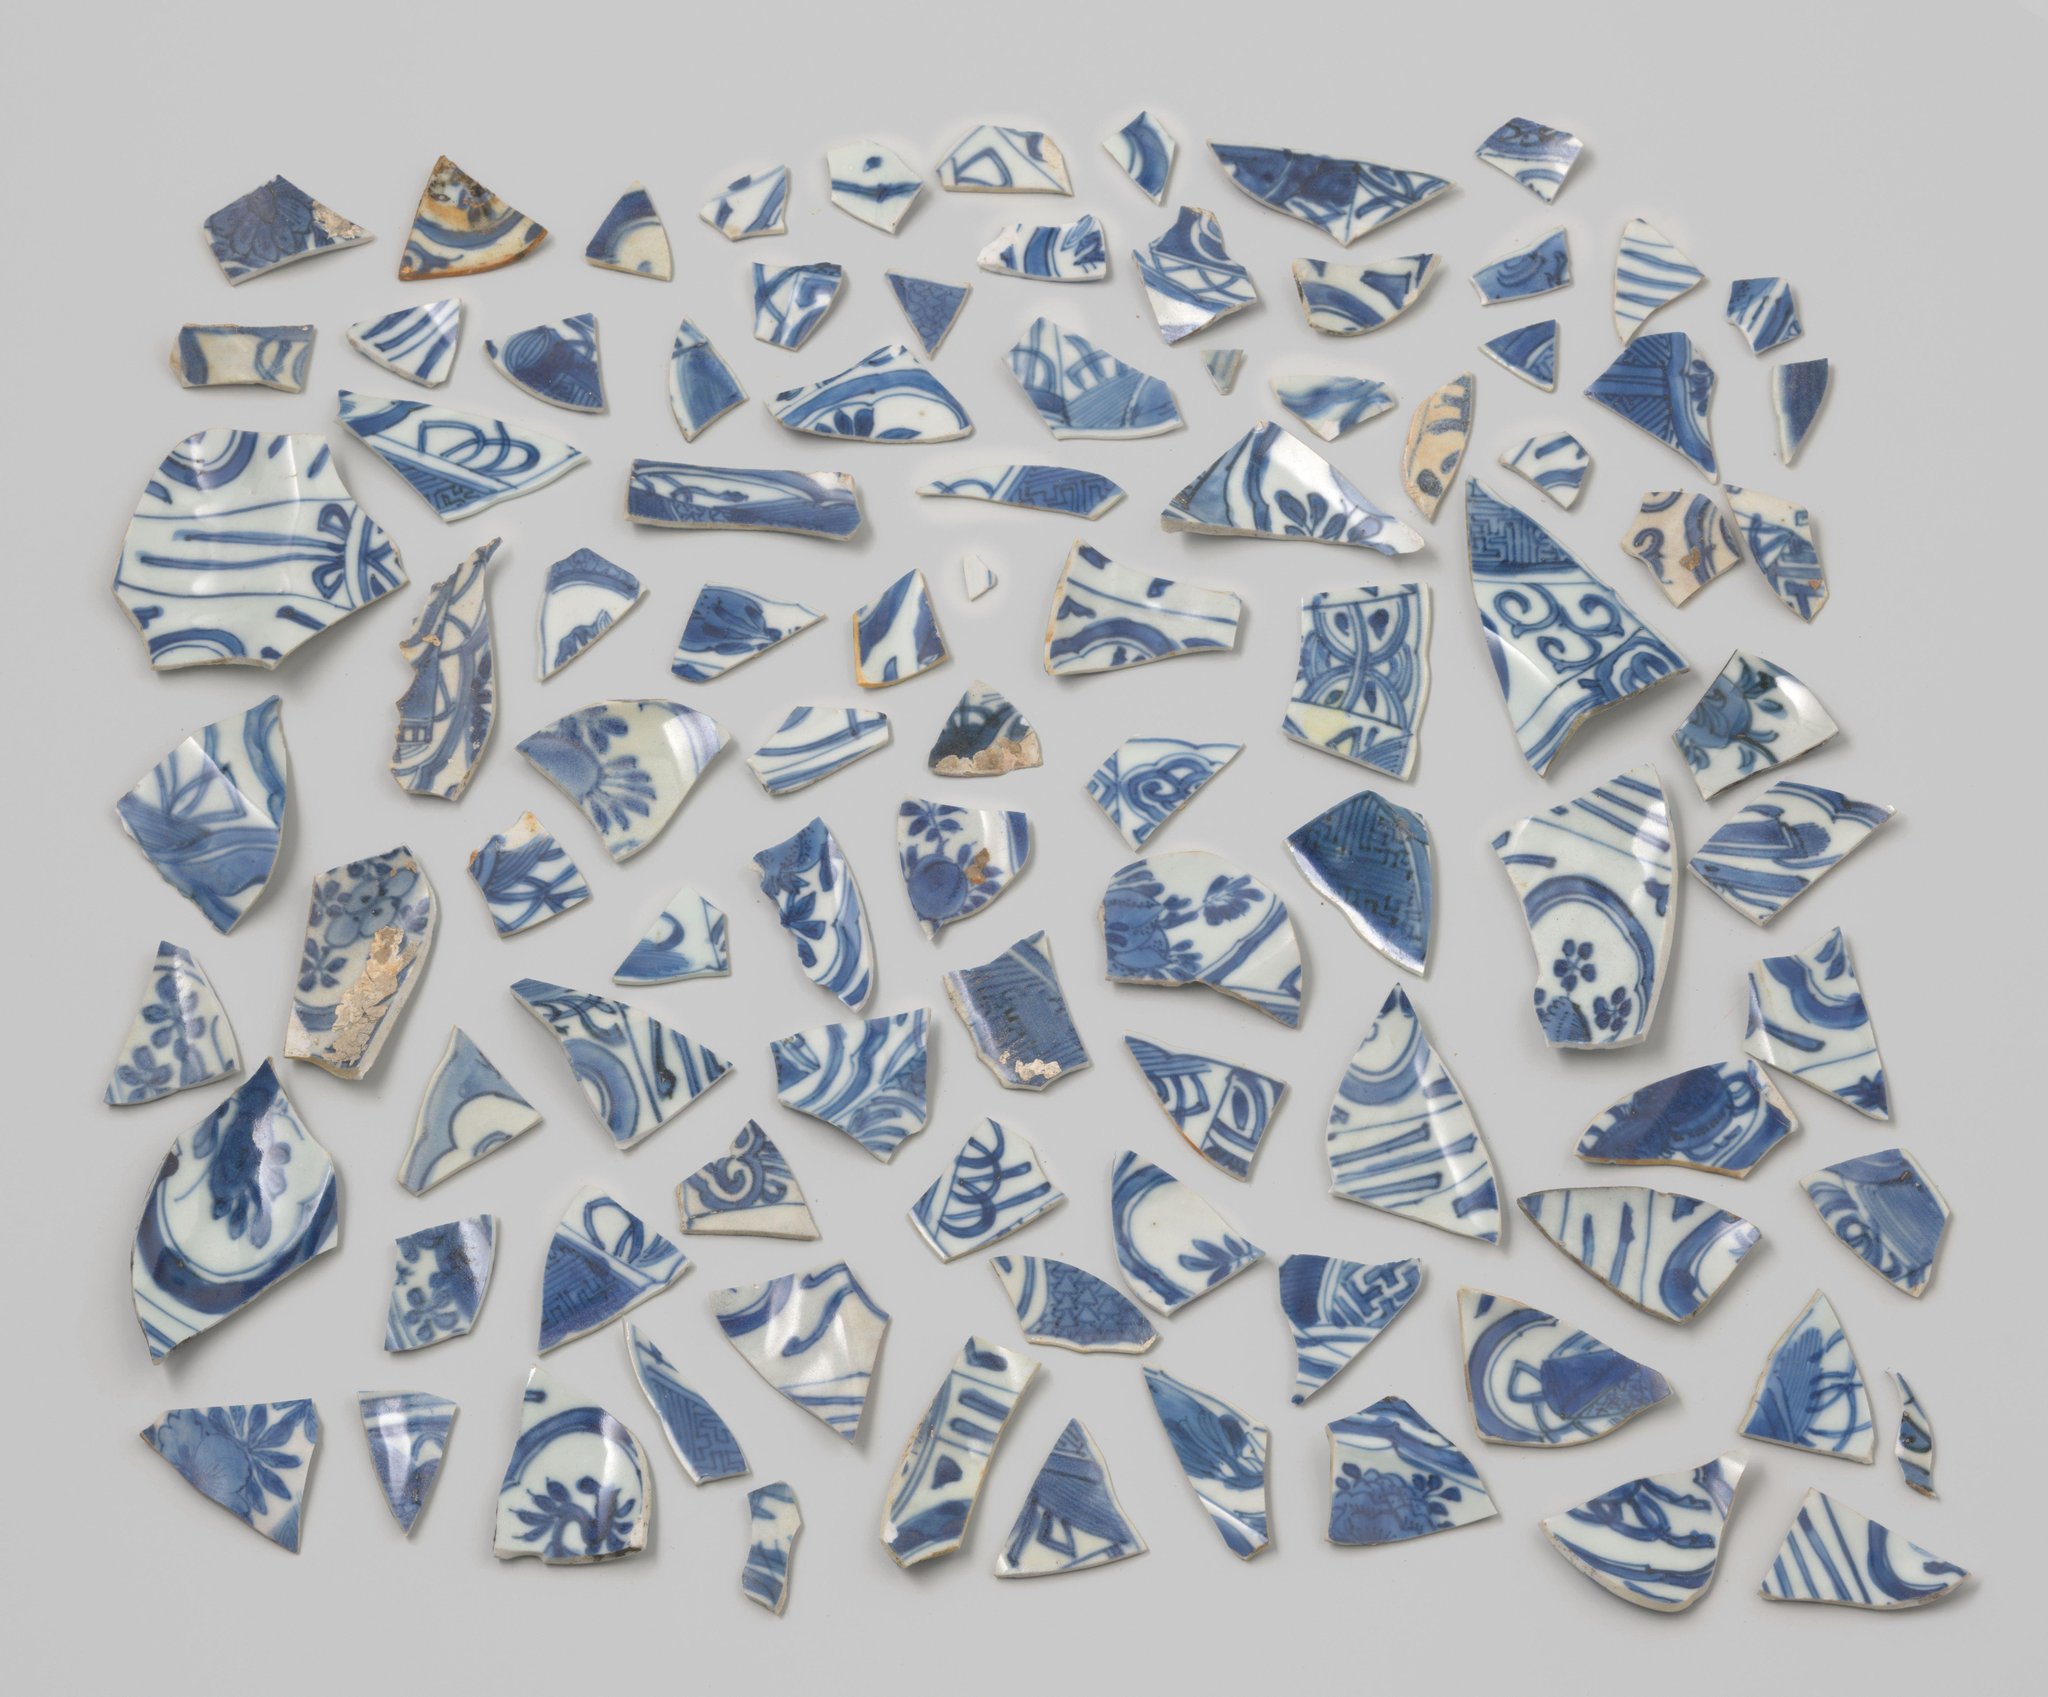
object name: sherd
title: Scherven kraakporselein uit V.O.C.-schip de 'Witte Leeuw'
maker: Anonymous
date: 1613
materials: bone china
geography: jingdezhen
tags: verenigde oostindische compagnie, sint-helena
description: Scherven kraakporseleinen borden uit V.O.C.-schip de 'Witte Leeuw'.